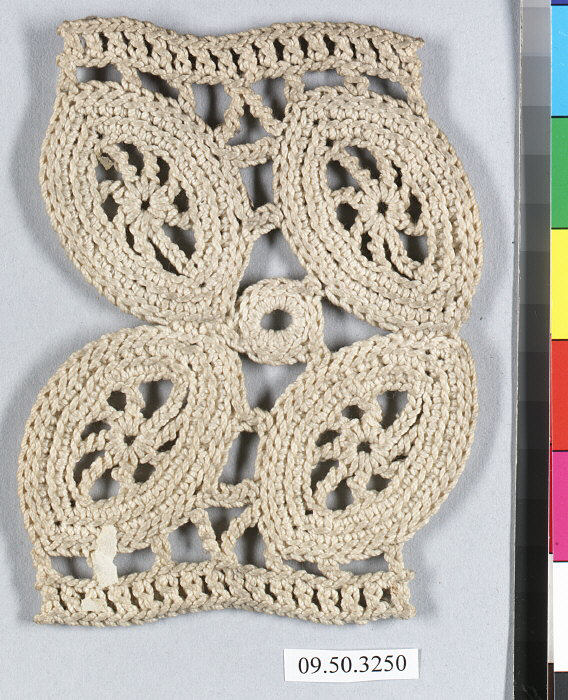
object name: sample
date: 1801-1900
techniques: crochet